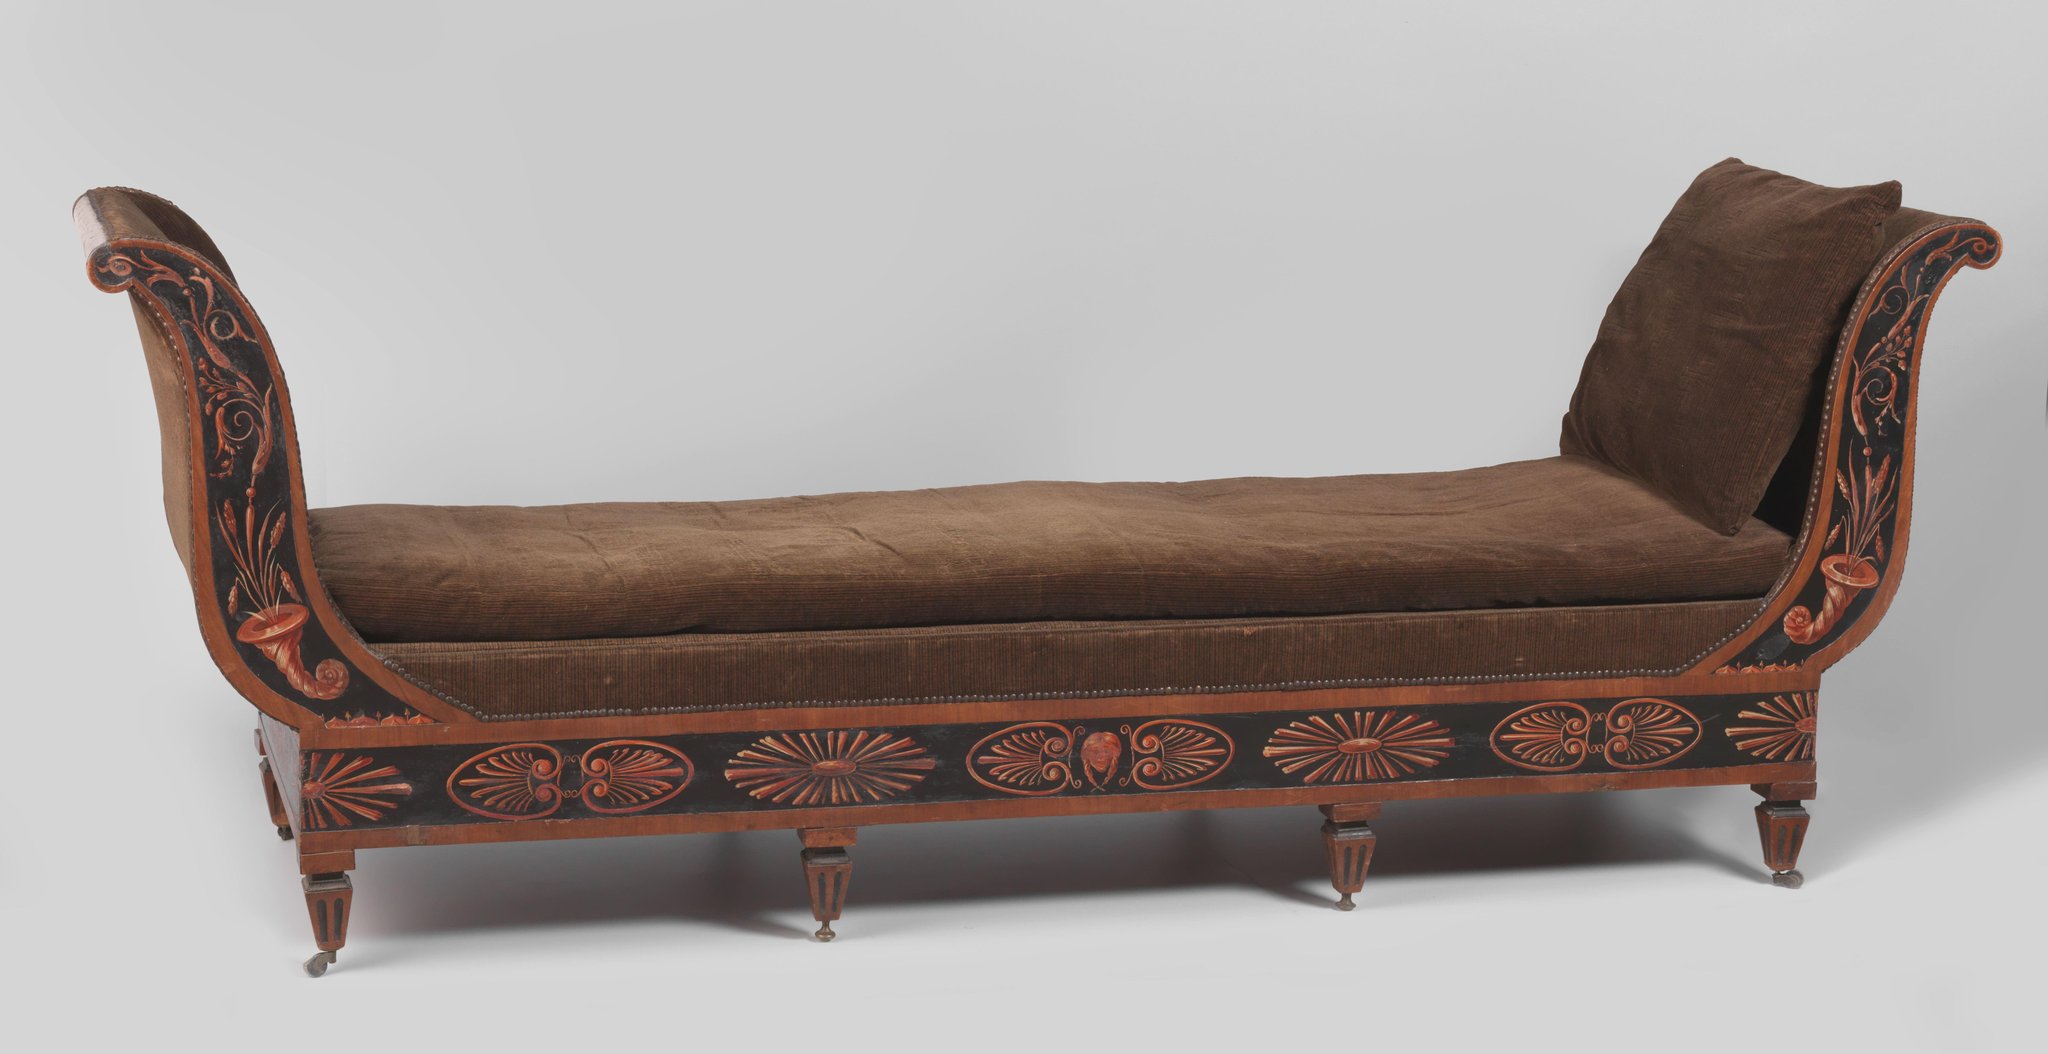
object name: furniture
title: Canapé van mahoniefineer op eiken, bekleed en à l'Etrusque beschilderd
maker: Anonymous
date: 1785-1800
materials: wood, textile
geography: netherlands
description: Canapé van mahoniefineer op eiken, bekleed en "à l'étrusque" beschilderd, rustend op acht vierkante, zich naar onderen verjongende poten met cannelures. De zitregels zijn op zwarte grond in roodbruin en wit beschilderd met palmetten, afgewisseld door stralenkransen. Tussen de middelste palmetten een vrouwenkop met vlechten. De aan de beide uiteinden geplaatste, gestrekte S-vormige leuningen zijn in dezelfde kleuren beschilderd met hoornen des overvloeds, waaruit korenaren en bloemranken ontspruiten.